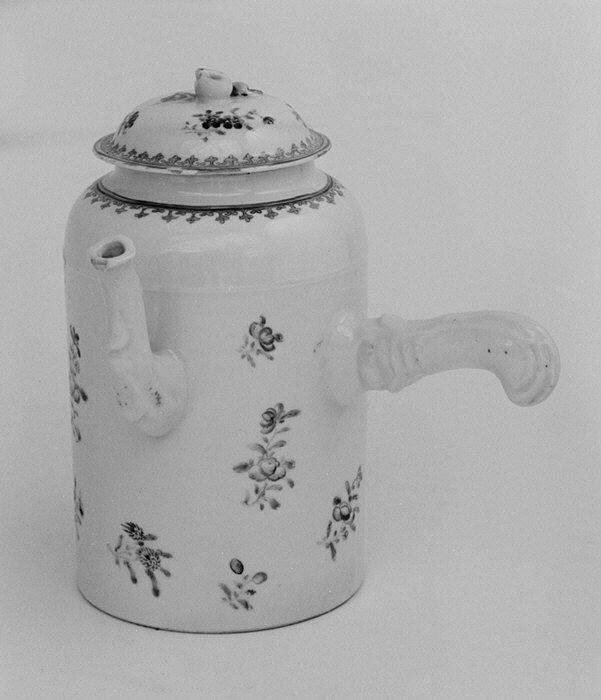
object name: chocolate pot with cover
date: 1760-1770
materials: hard paste porcelain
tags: flowers